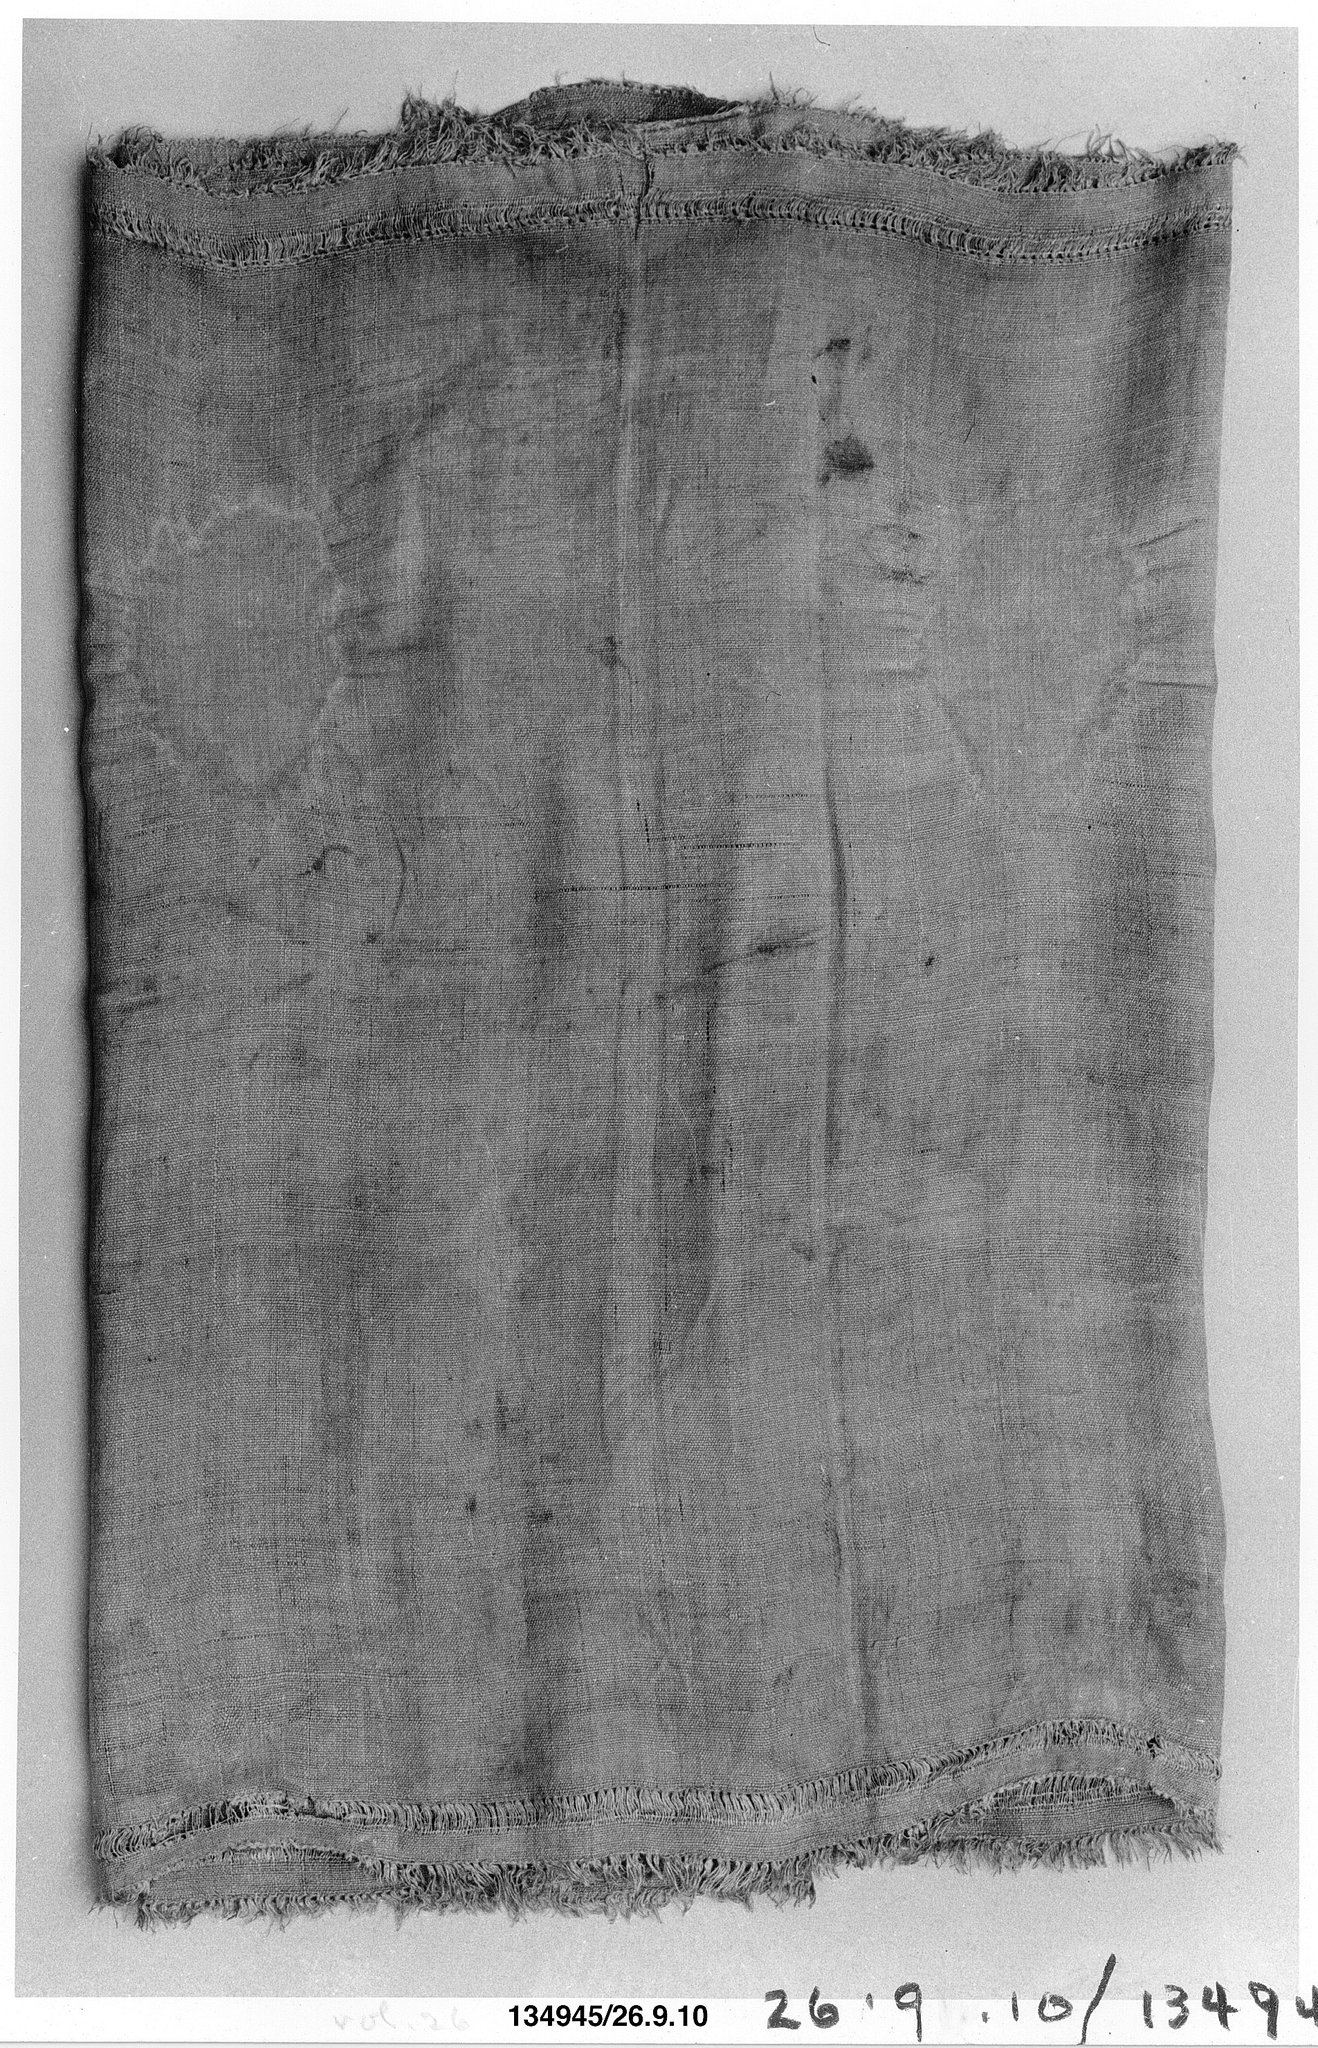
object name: scarf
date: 301-500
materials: linen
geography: egypt